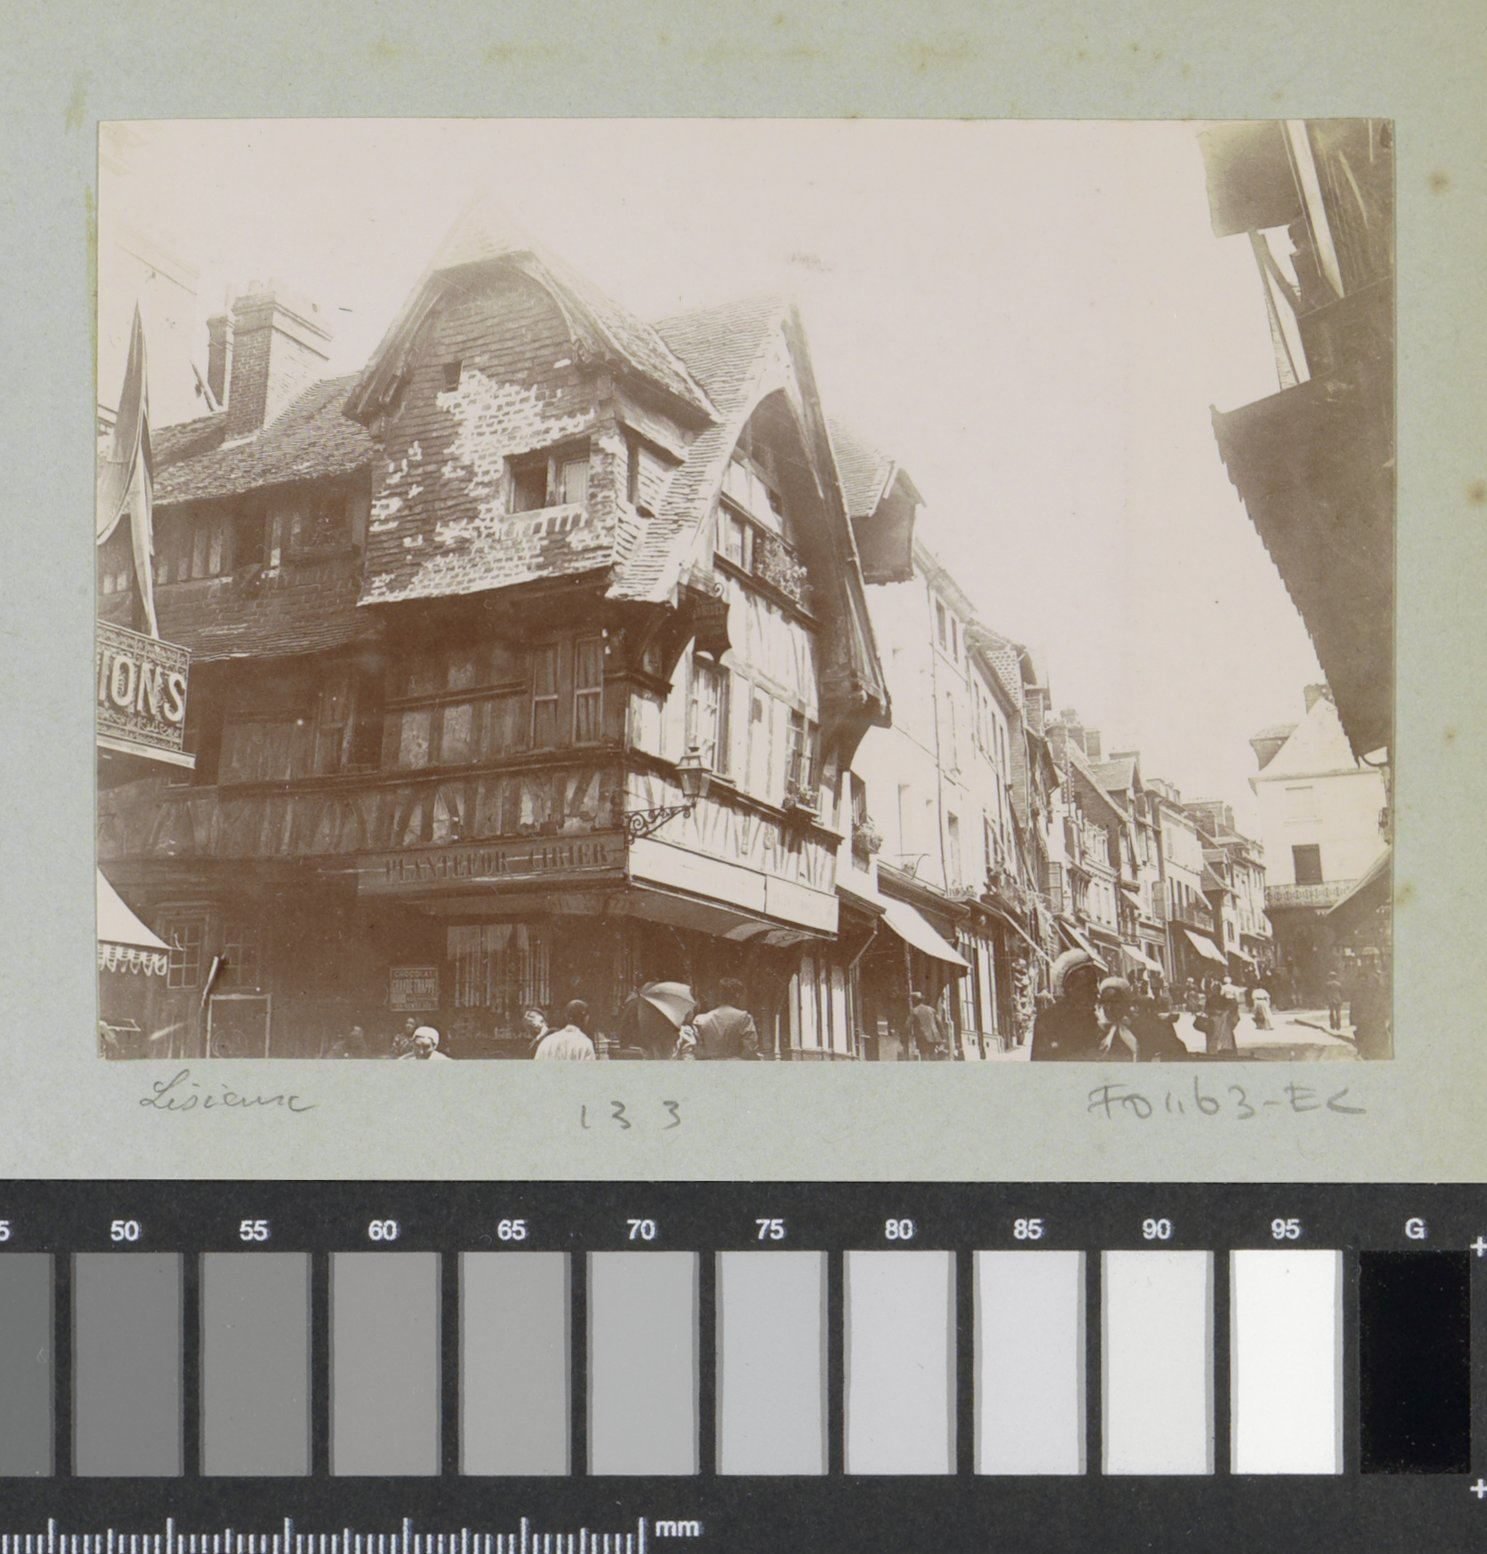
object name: photograph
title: La Grande-Rue in Lisieux met op de hoek een huis met opschrift 'Plantefor Cirier'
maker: delizy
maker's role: manufacturer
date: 1808-1897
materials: paper, photographic support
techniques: gelatin silver print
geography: lisieux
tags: façade (of house or building), street (+ city(-scape) with figures, staffage)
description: Onderdeel van Fotoalbum van een Franse amateurfotograaf met opnames van uitstapjes in Frankrijk, Spanje, België, Luxemburg en Nederland, de eerste automobielen en autoraces.